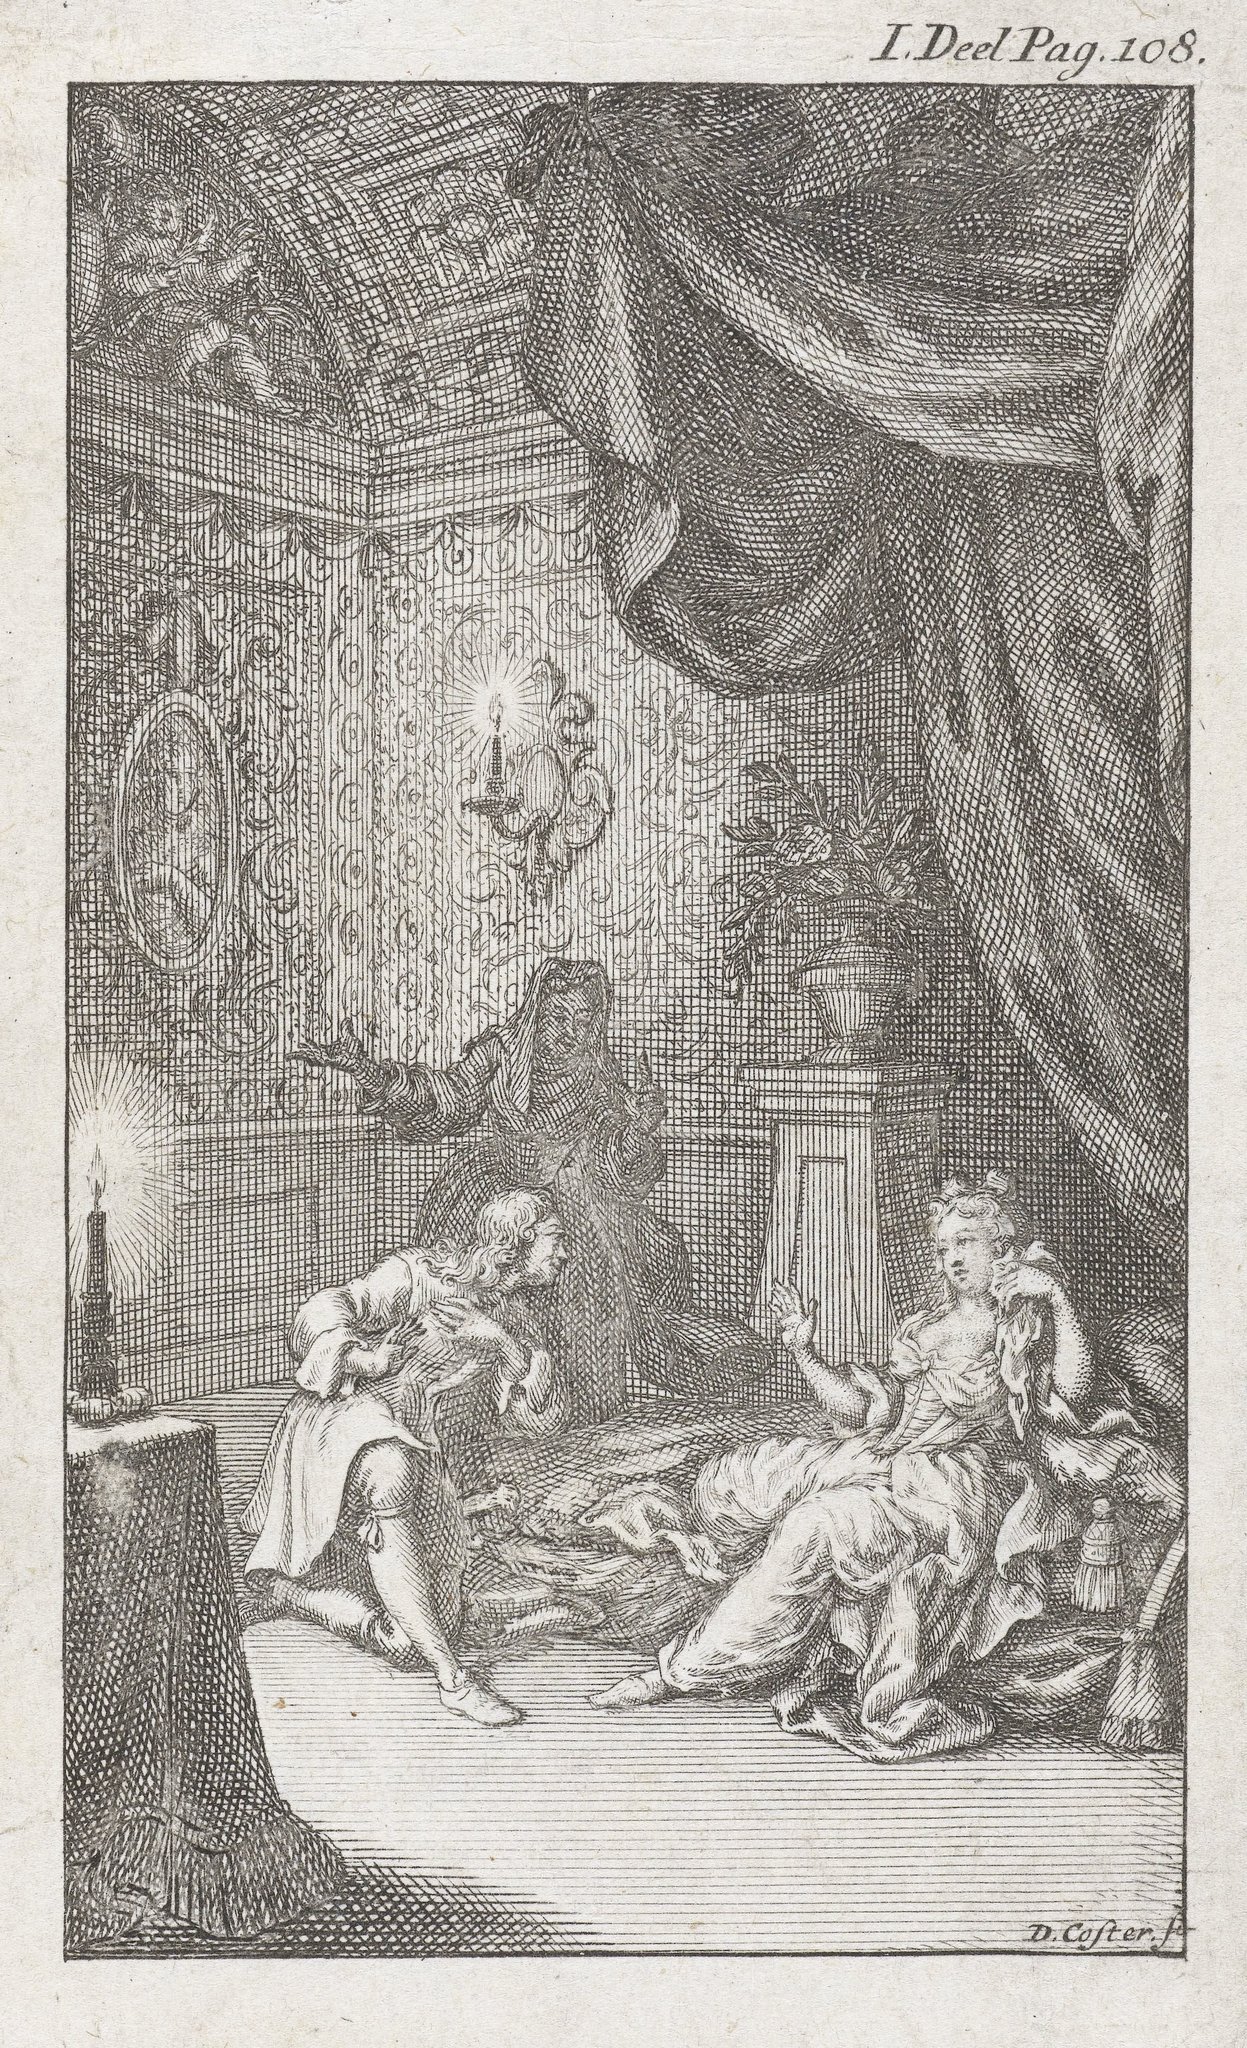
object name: book illustration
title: Huwelijksaanzoek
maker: david coster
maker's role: print maker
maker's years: 1676-1752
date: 1700-1752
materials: paper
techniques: engraving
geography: the hague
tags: man kneeling before his beloved (proposing)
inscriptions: collector's mark: Lugt 2228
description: Een jonge man knielt neer voor een vrouw, een hand op zijn borst. De vrouw ligt op een halfhoge bank in een weelderig versierde kamer. Op de achtergrond een oudere vrouw met een hoofddoek.